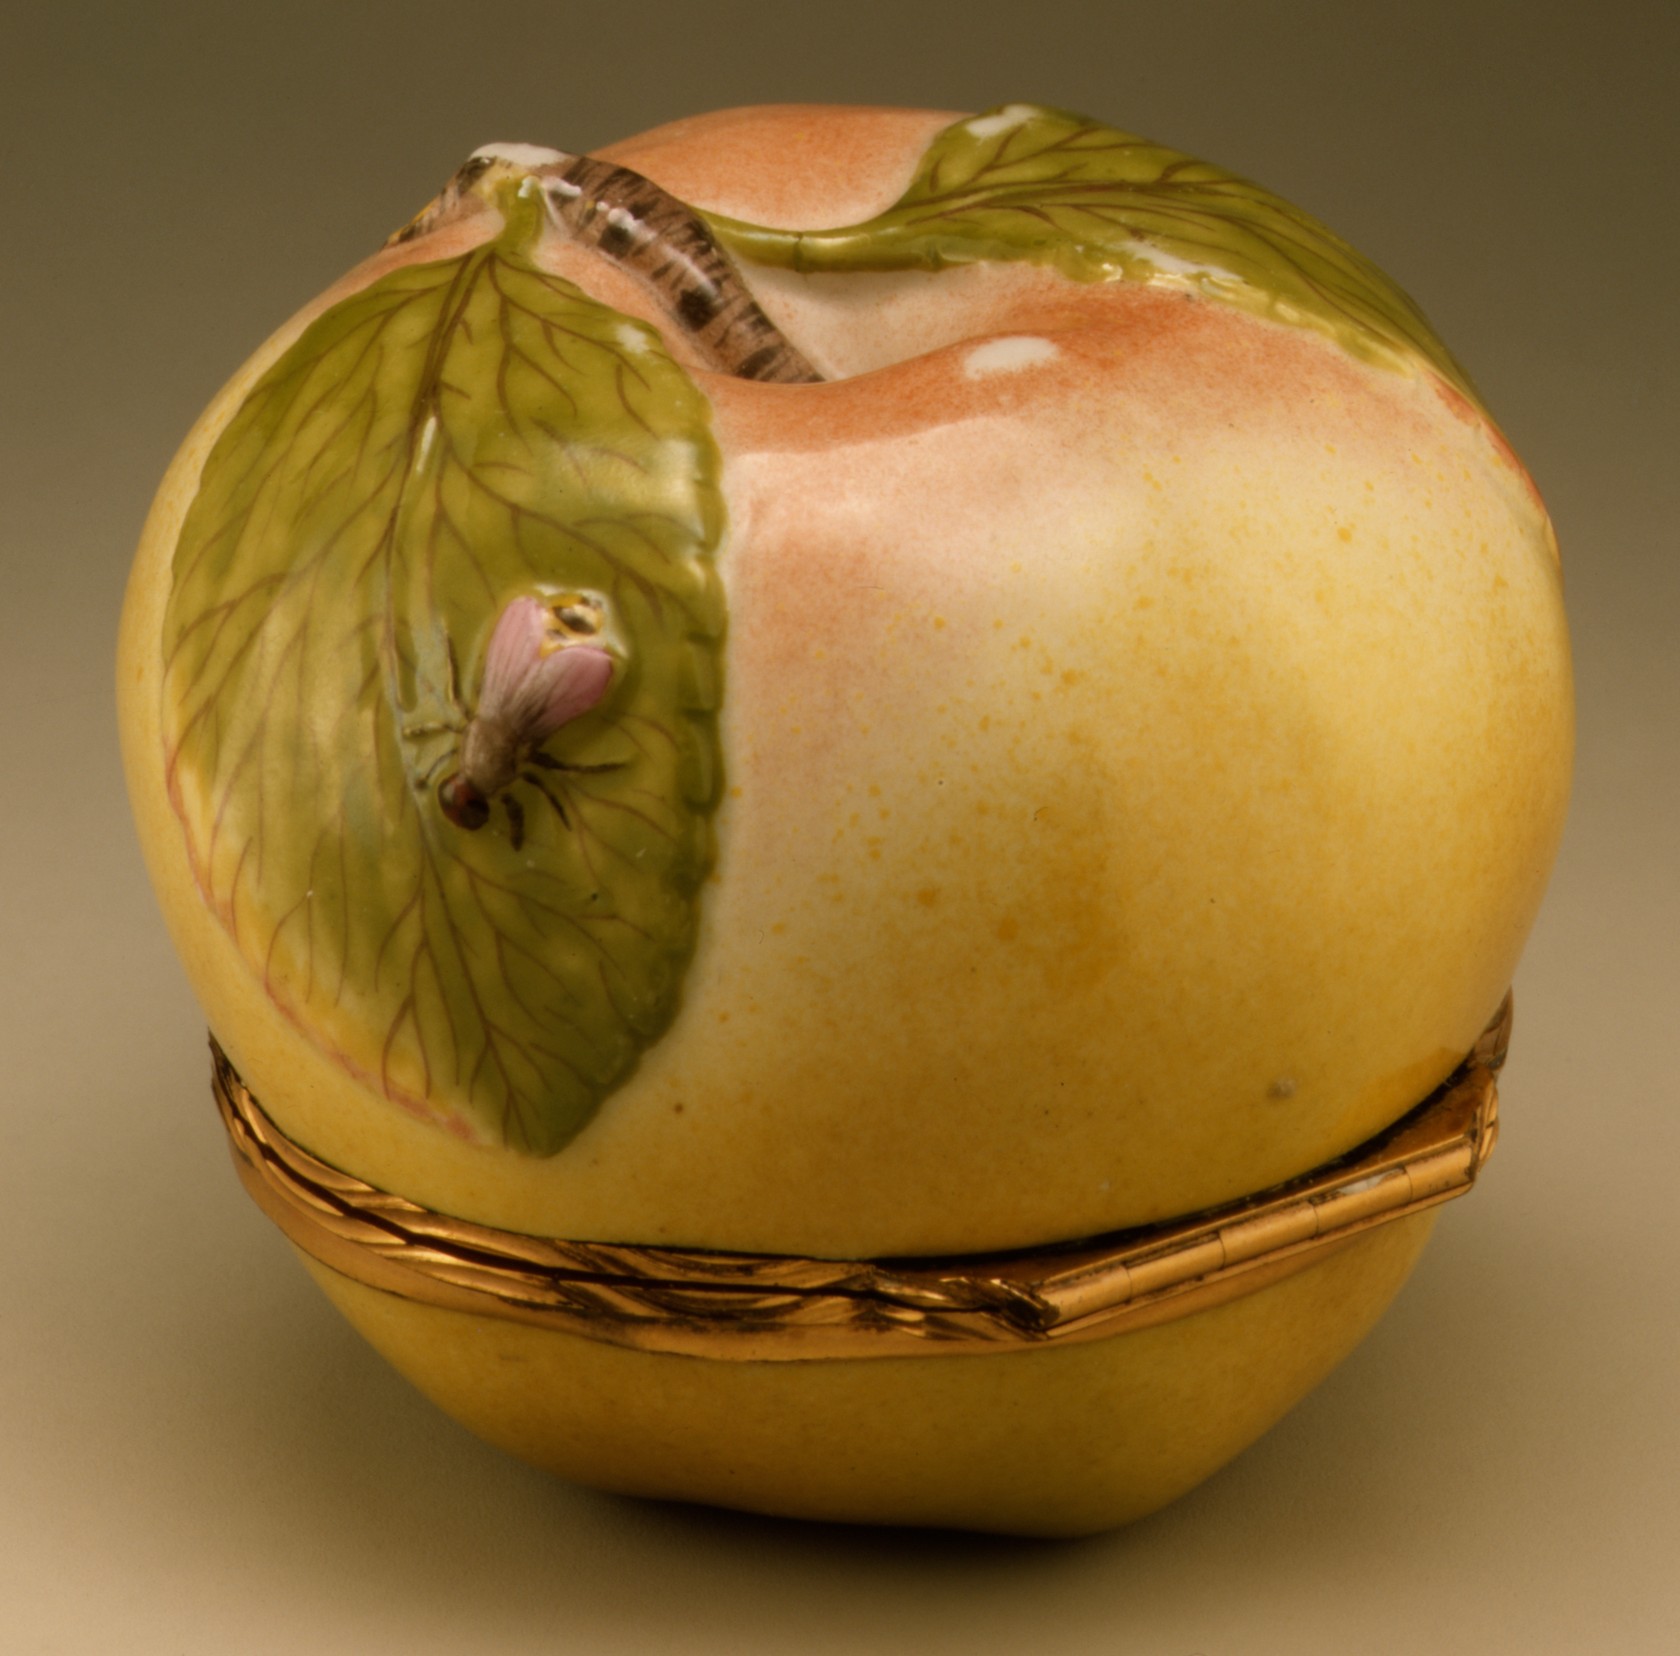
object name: snuffbox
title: Snuffbox in the form of an apple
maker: meissen manufactory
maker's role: manufactory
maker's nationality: german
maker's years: 1710-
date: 1740-1750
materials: gilt, hard paste porcelain, metal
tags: apples,insects